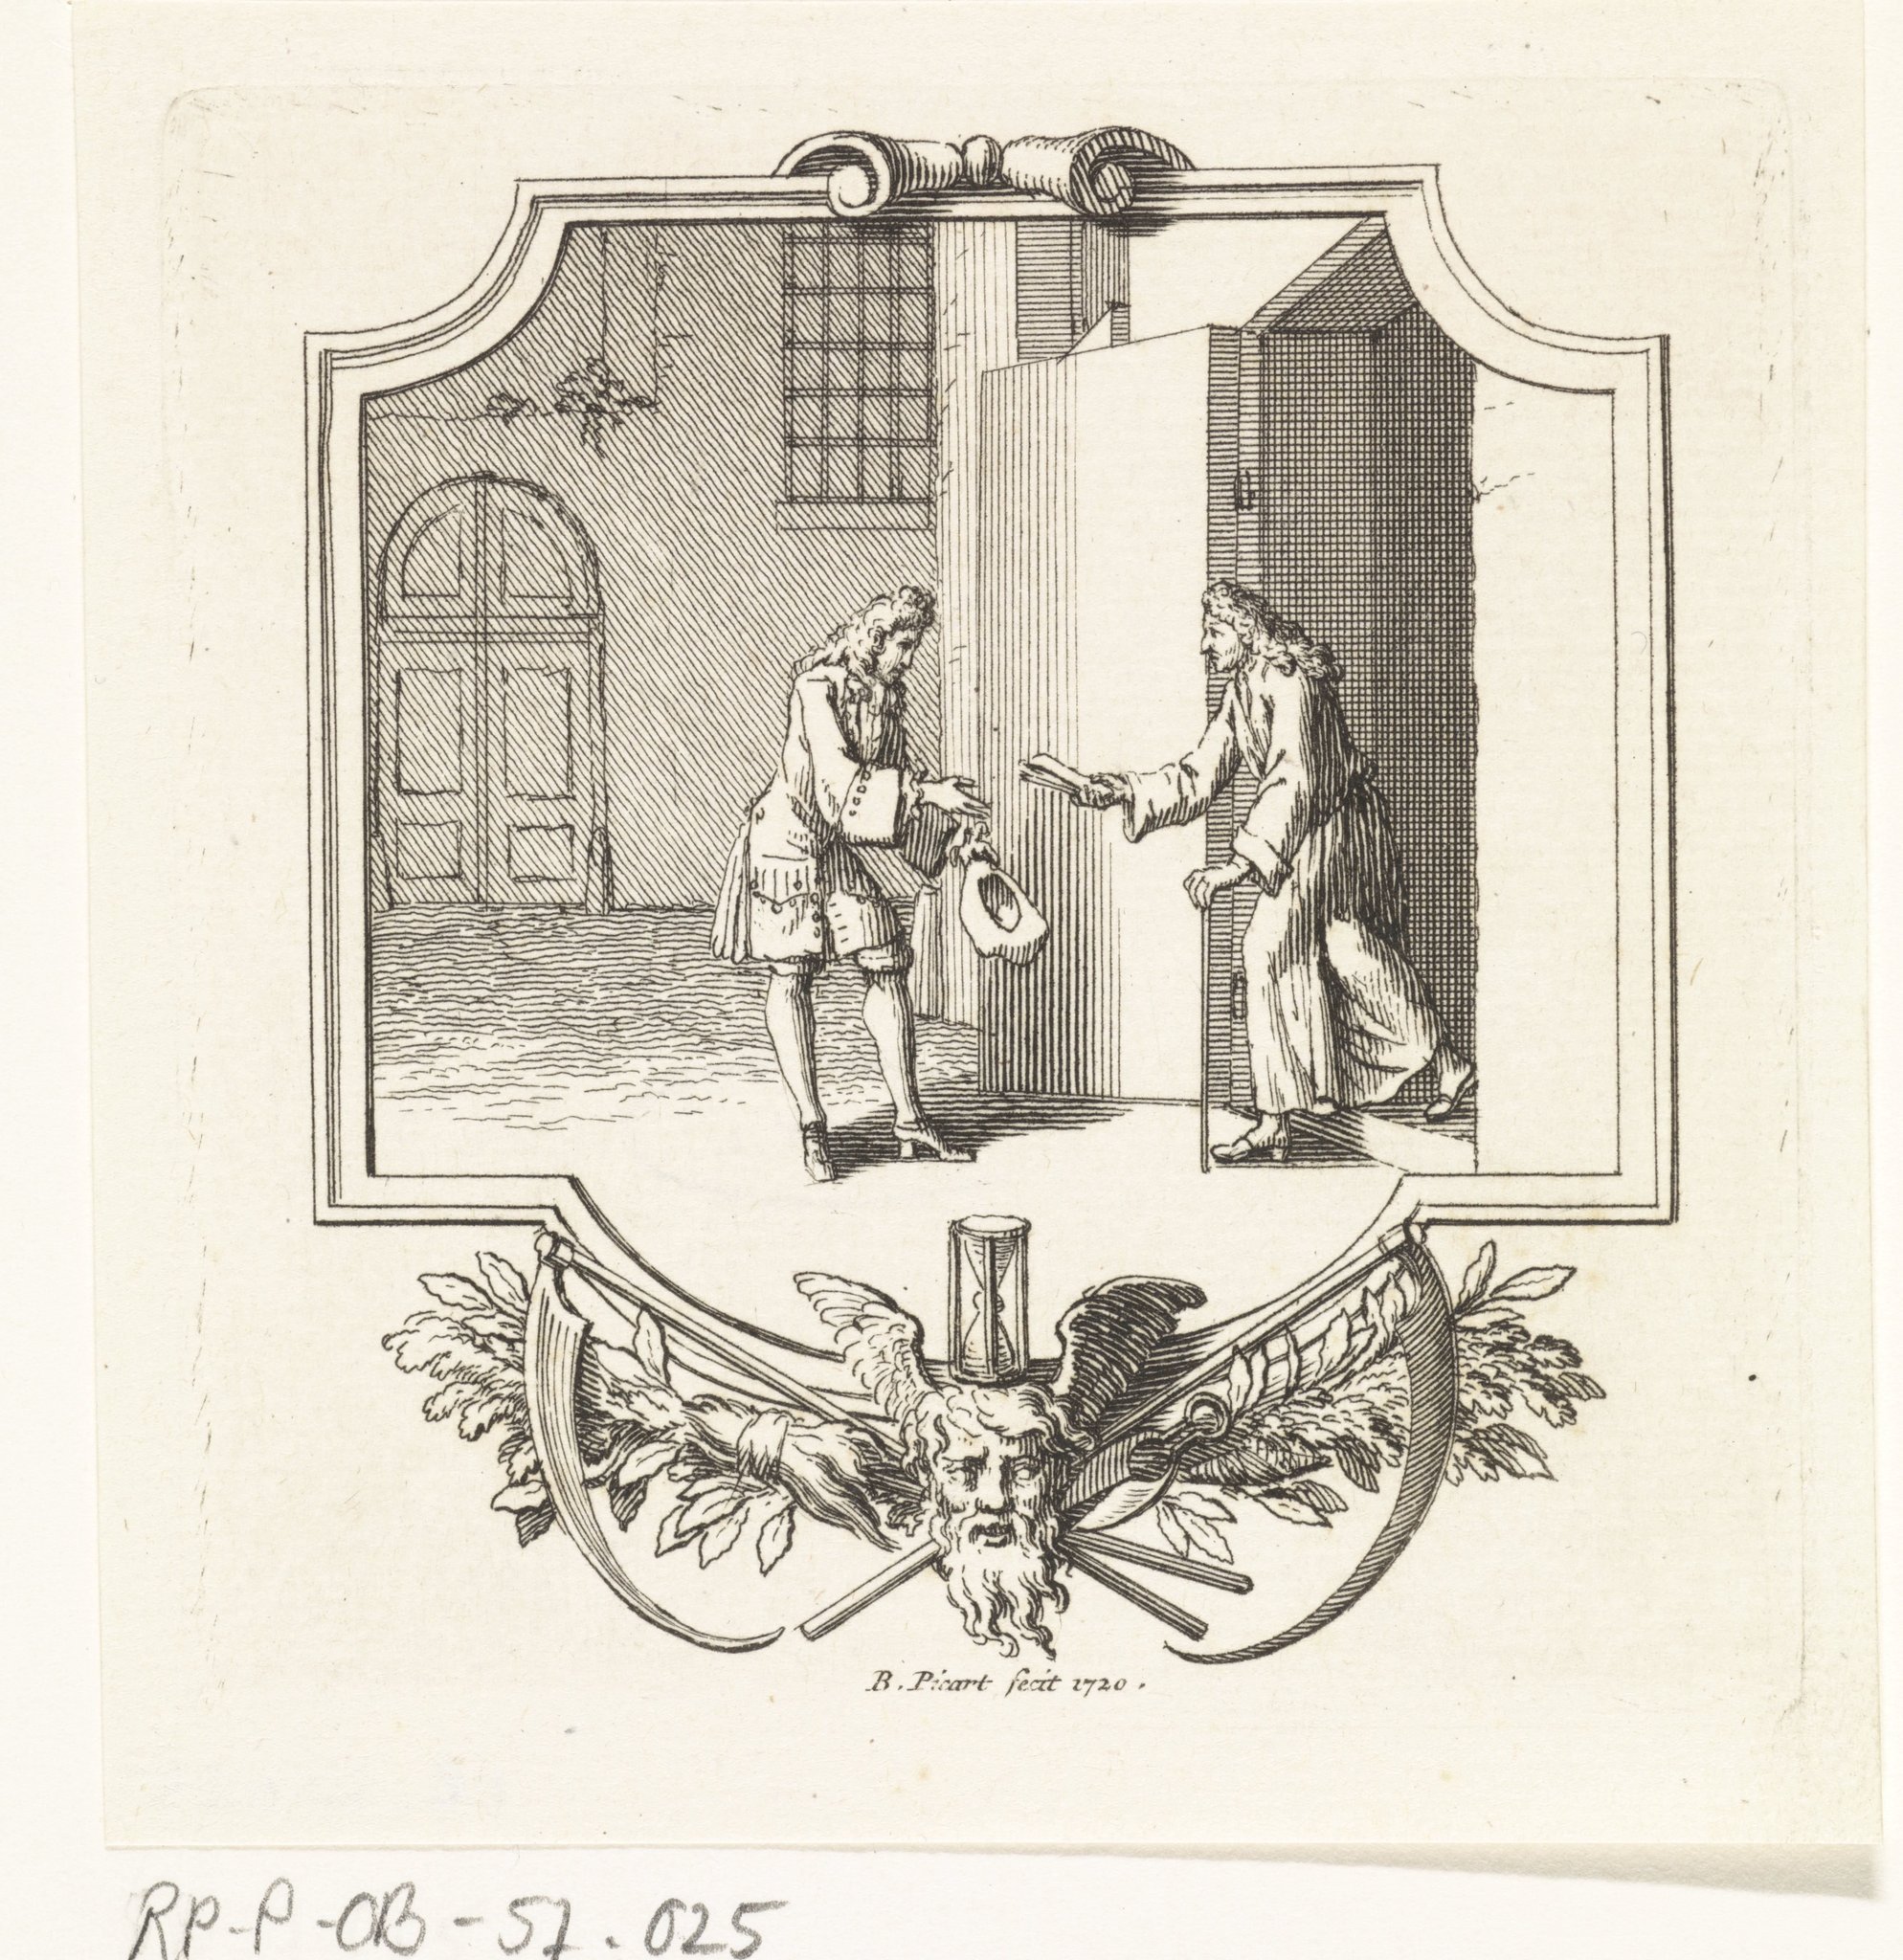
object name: print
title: Overhandigen van een brief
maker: bernard picart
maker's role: draughtsman, print maker, publisher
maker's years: 1673-1733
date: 1720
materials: paper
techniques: engraving, etching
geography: amsterdam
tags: messenger, father time, man with wings and scythe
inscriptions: collector's mark: Lugt 2228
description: Een man geeft een brief aan een man, die zijn hoed heeft afgenomen. Onder de voorstelling het gezicht en de attributen van Vader Tijd.